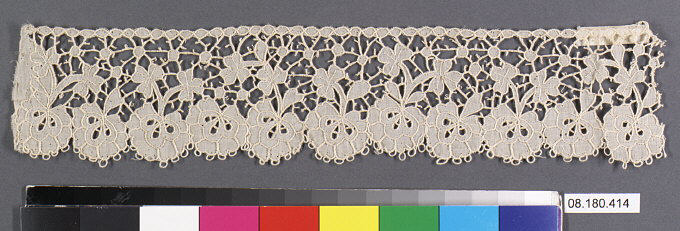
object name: fragment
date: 1801-1900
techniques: embroidery